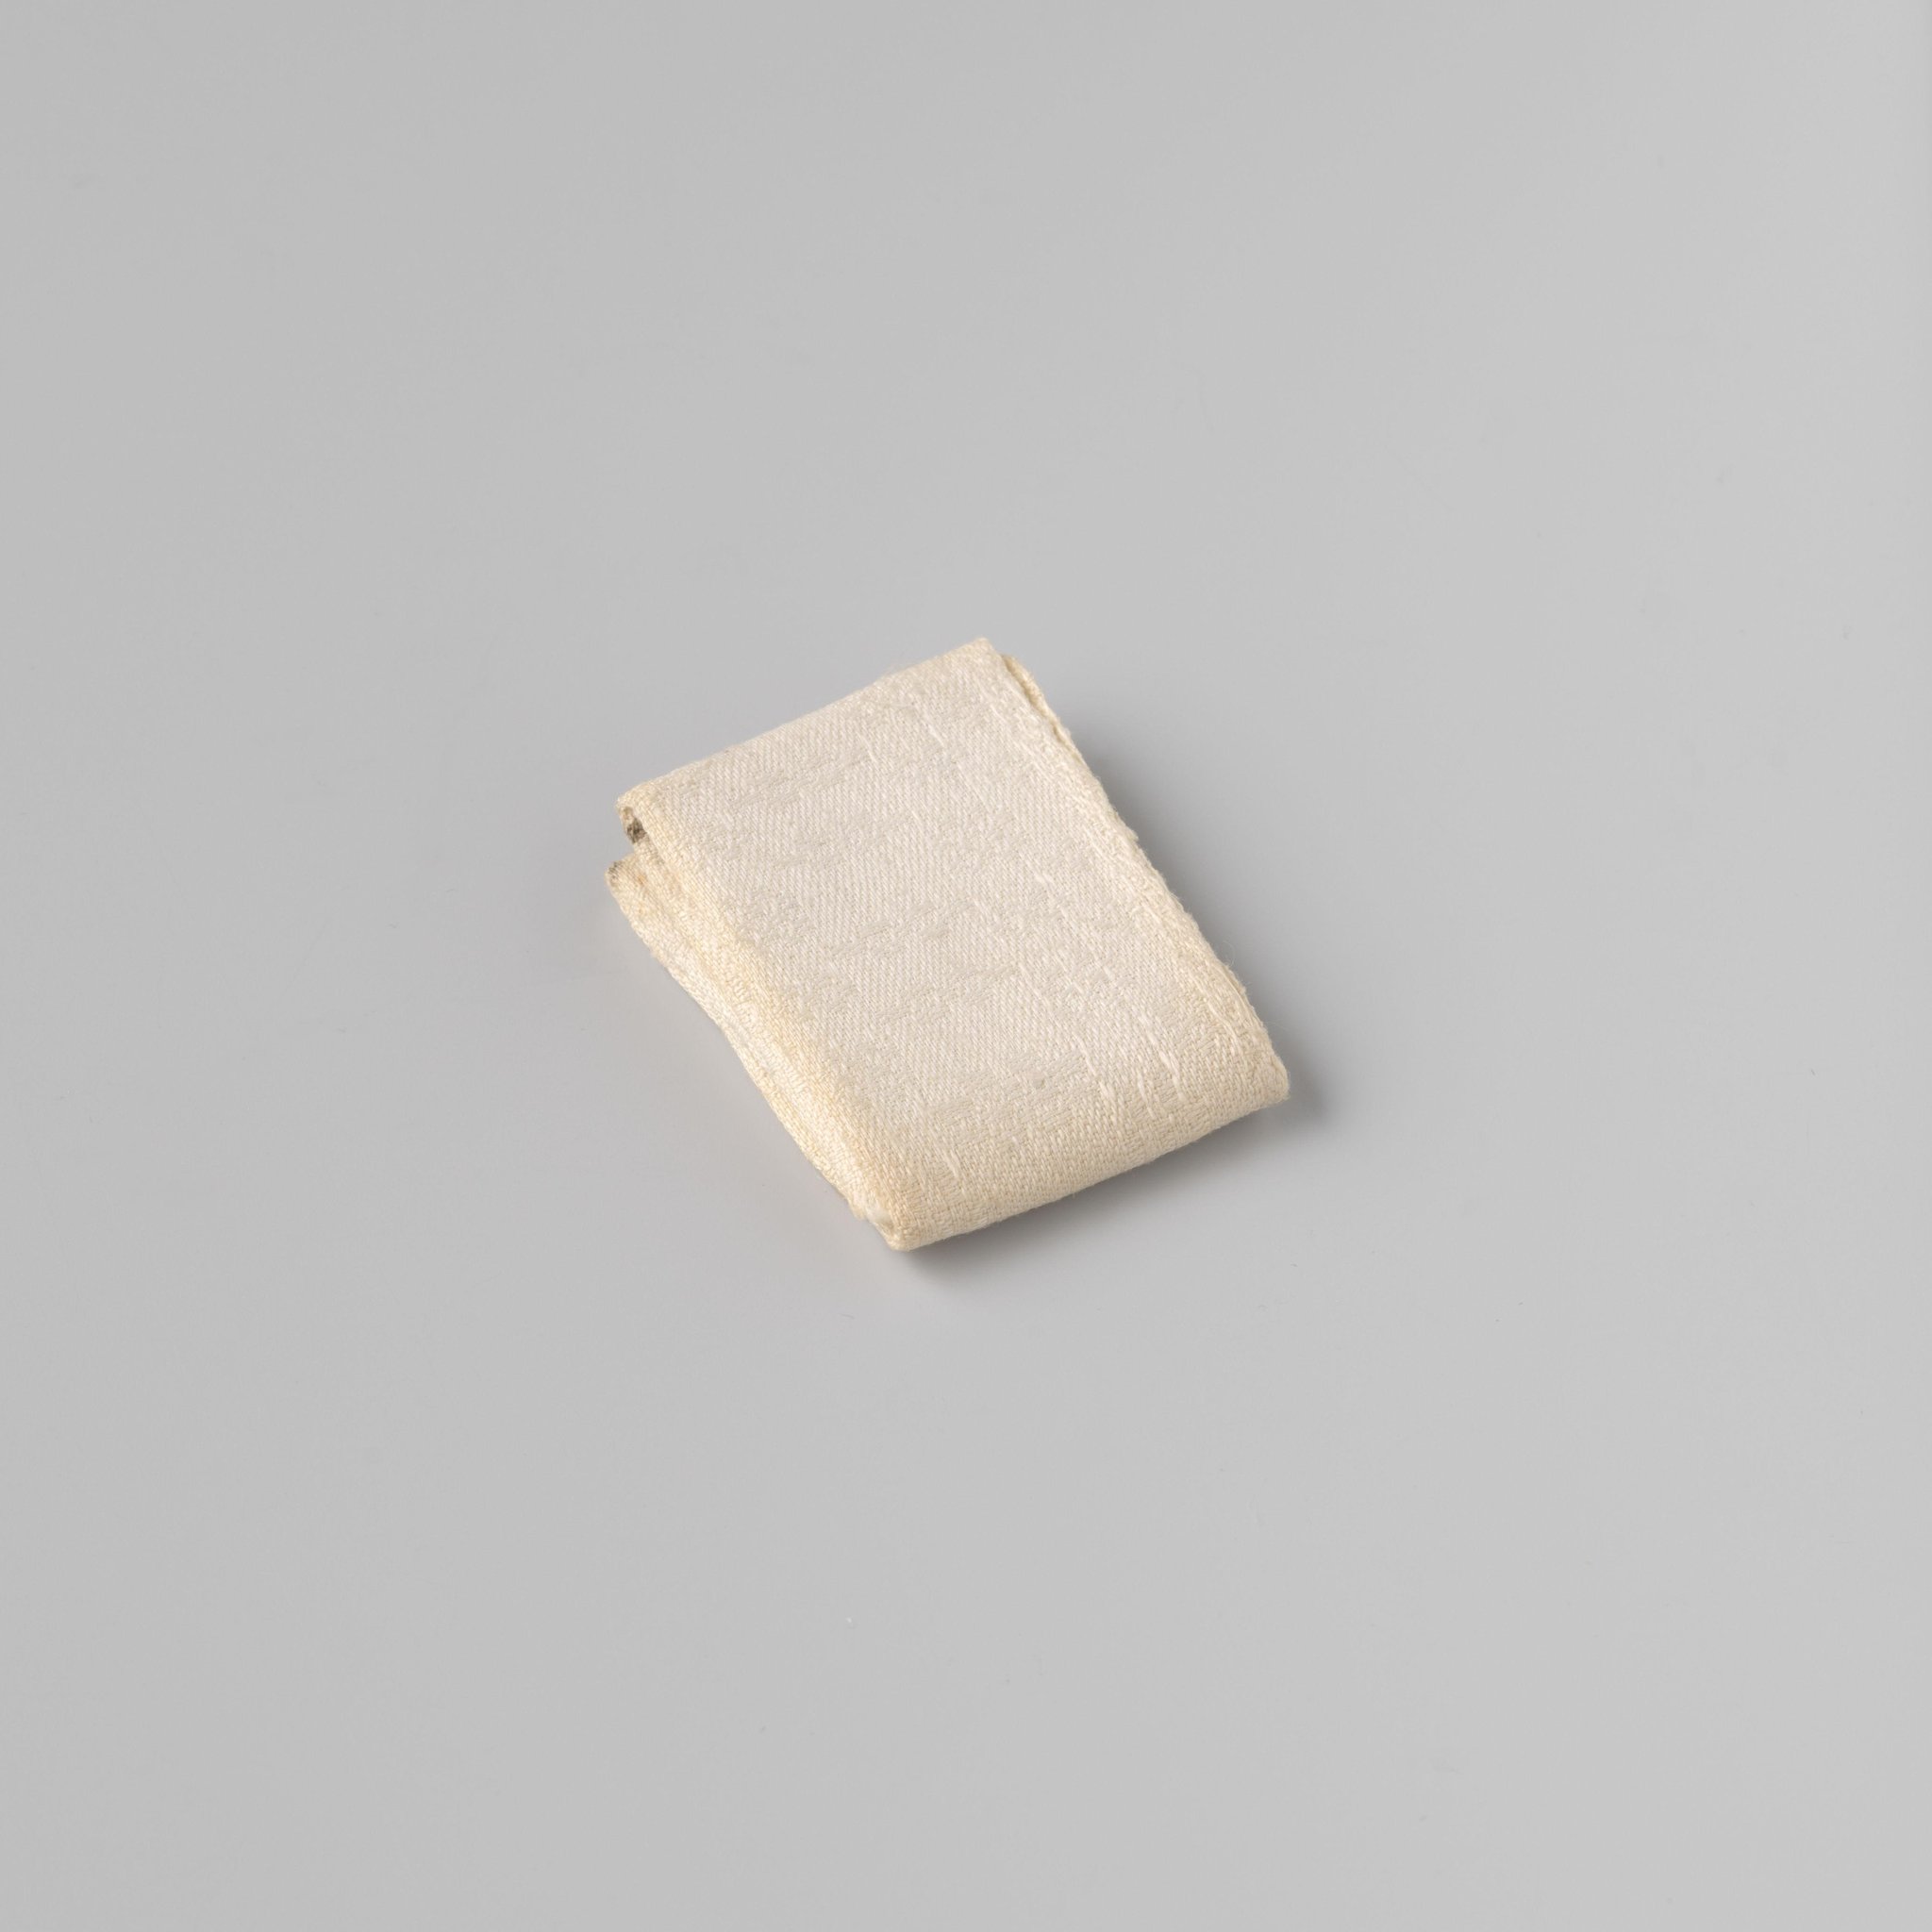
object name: miniature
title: Linnen servet van damastweefsel met pellenpatroon (motief III), geen zomen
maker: Anonymous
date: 1690-1710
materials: linen